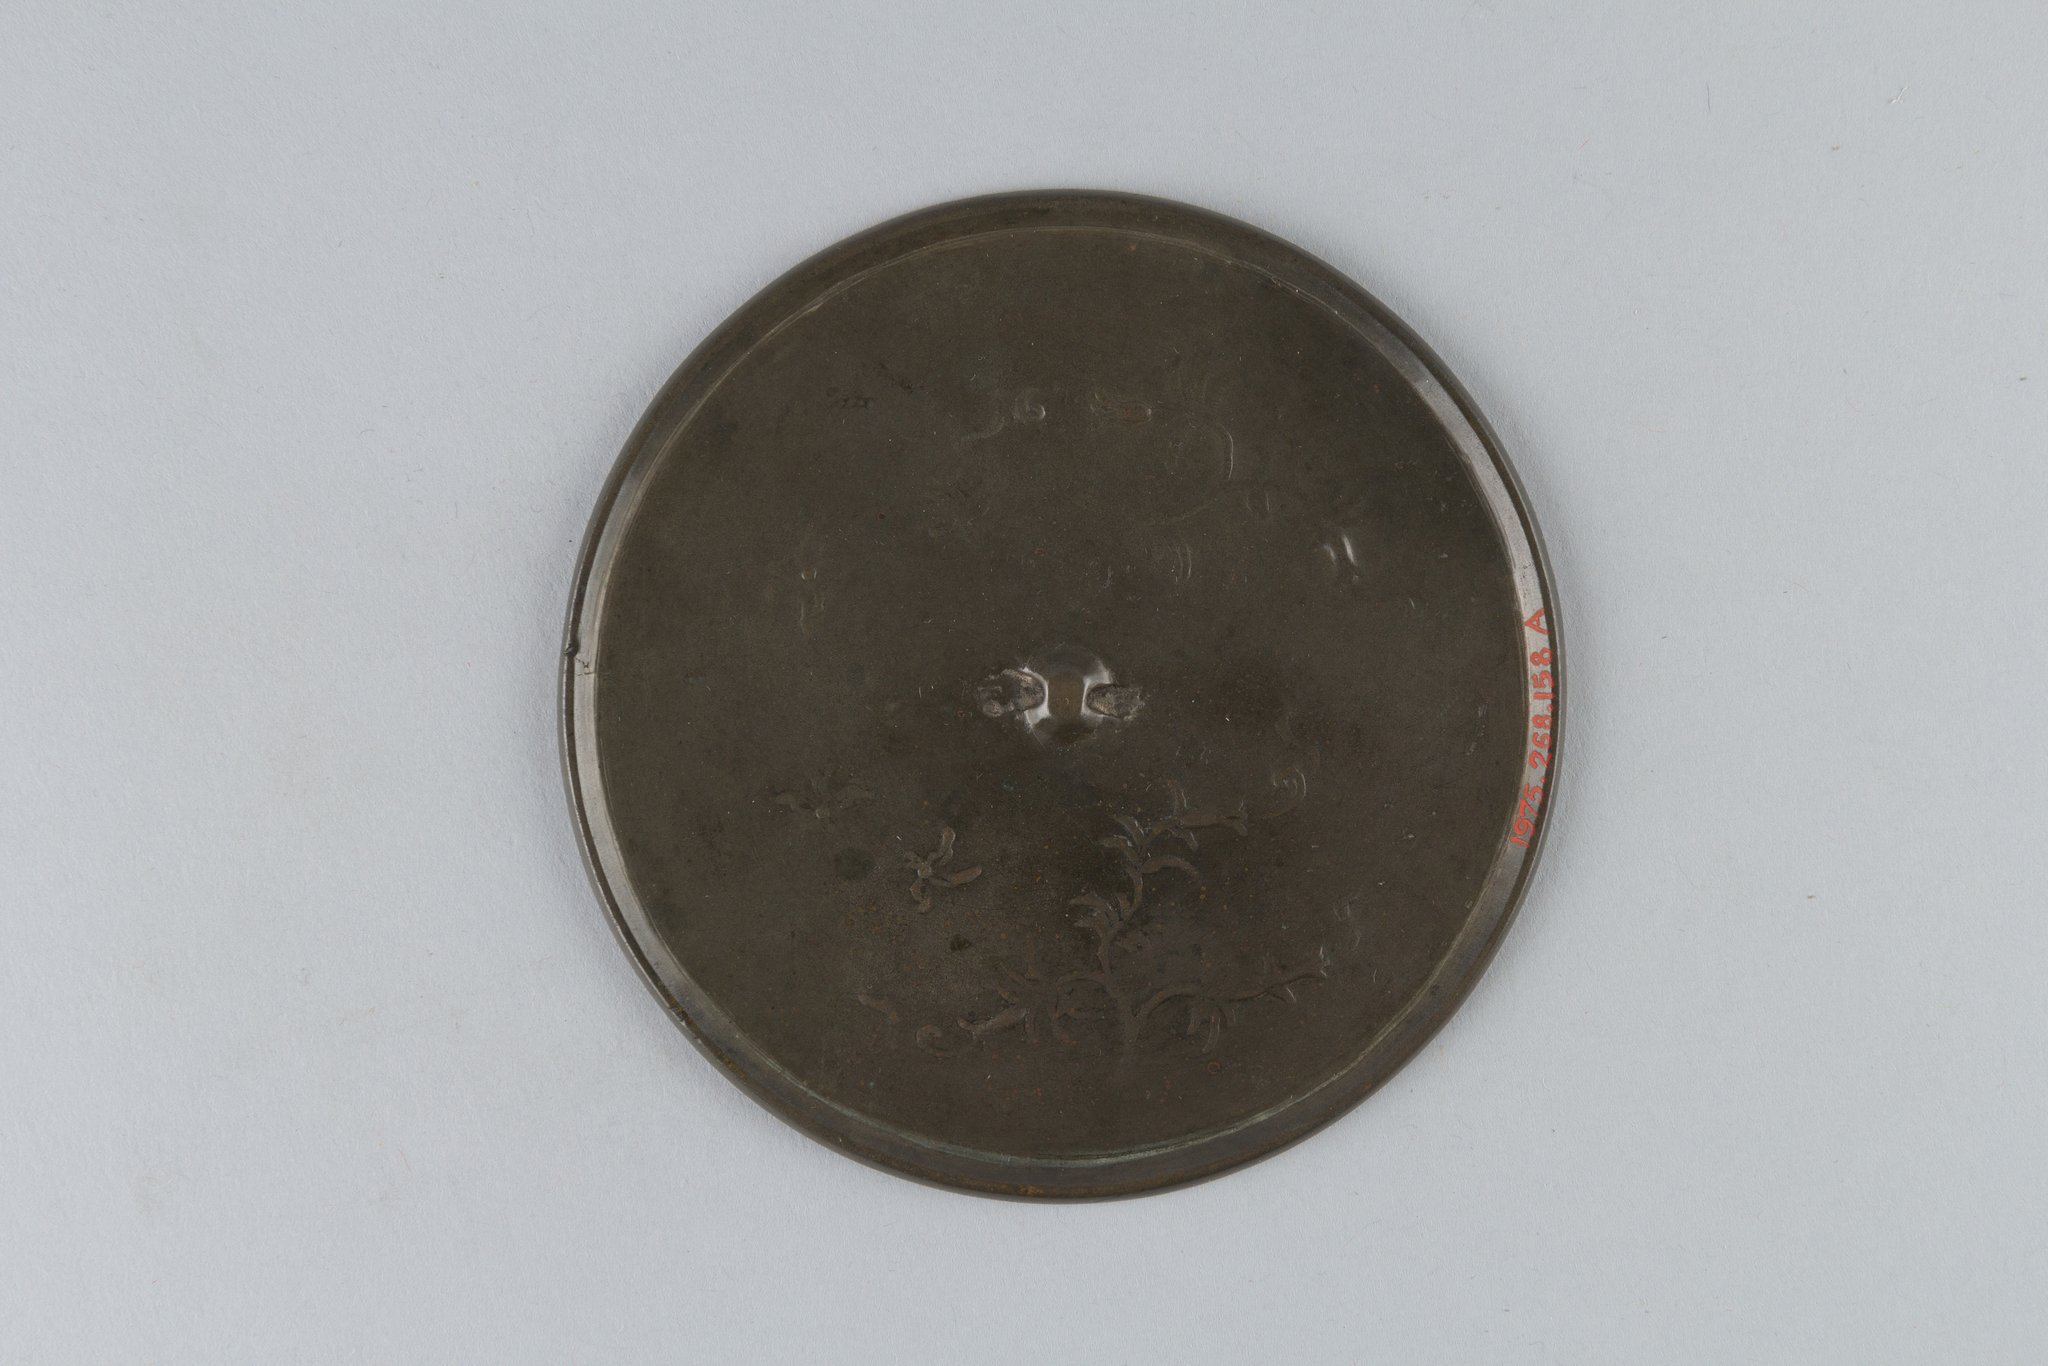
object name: mirror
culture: japanese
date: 794-1185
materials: bronze